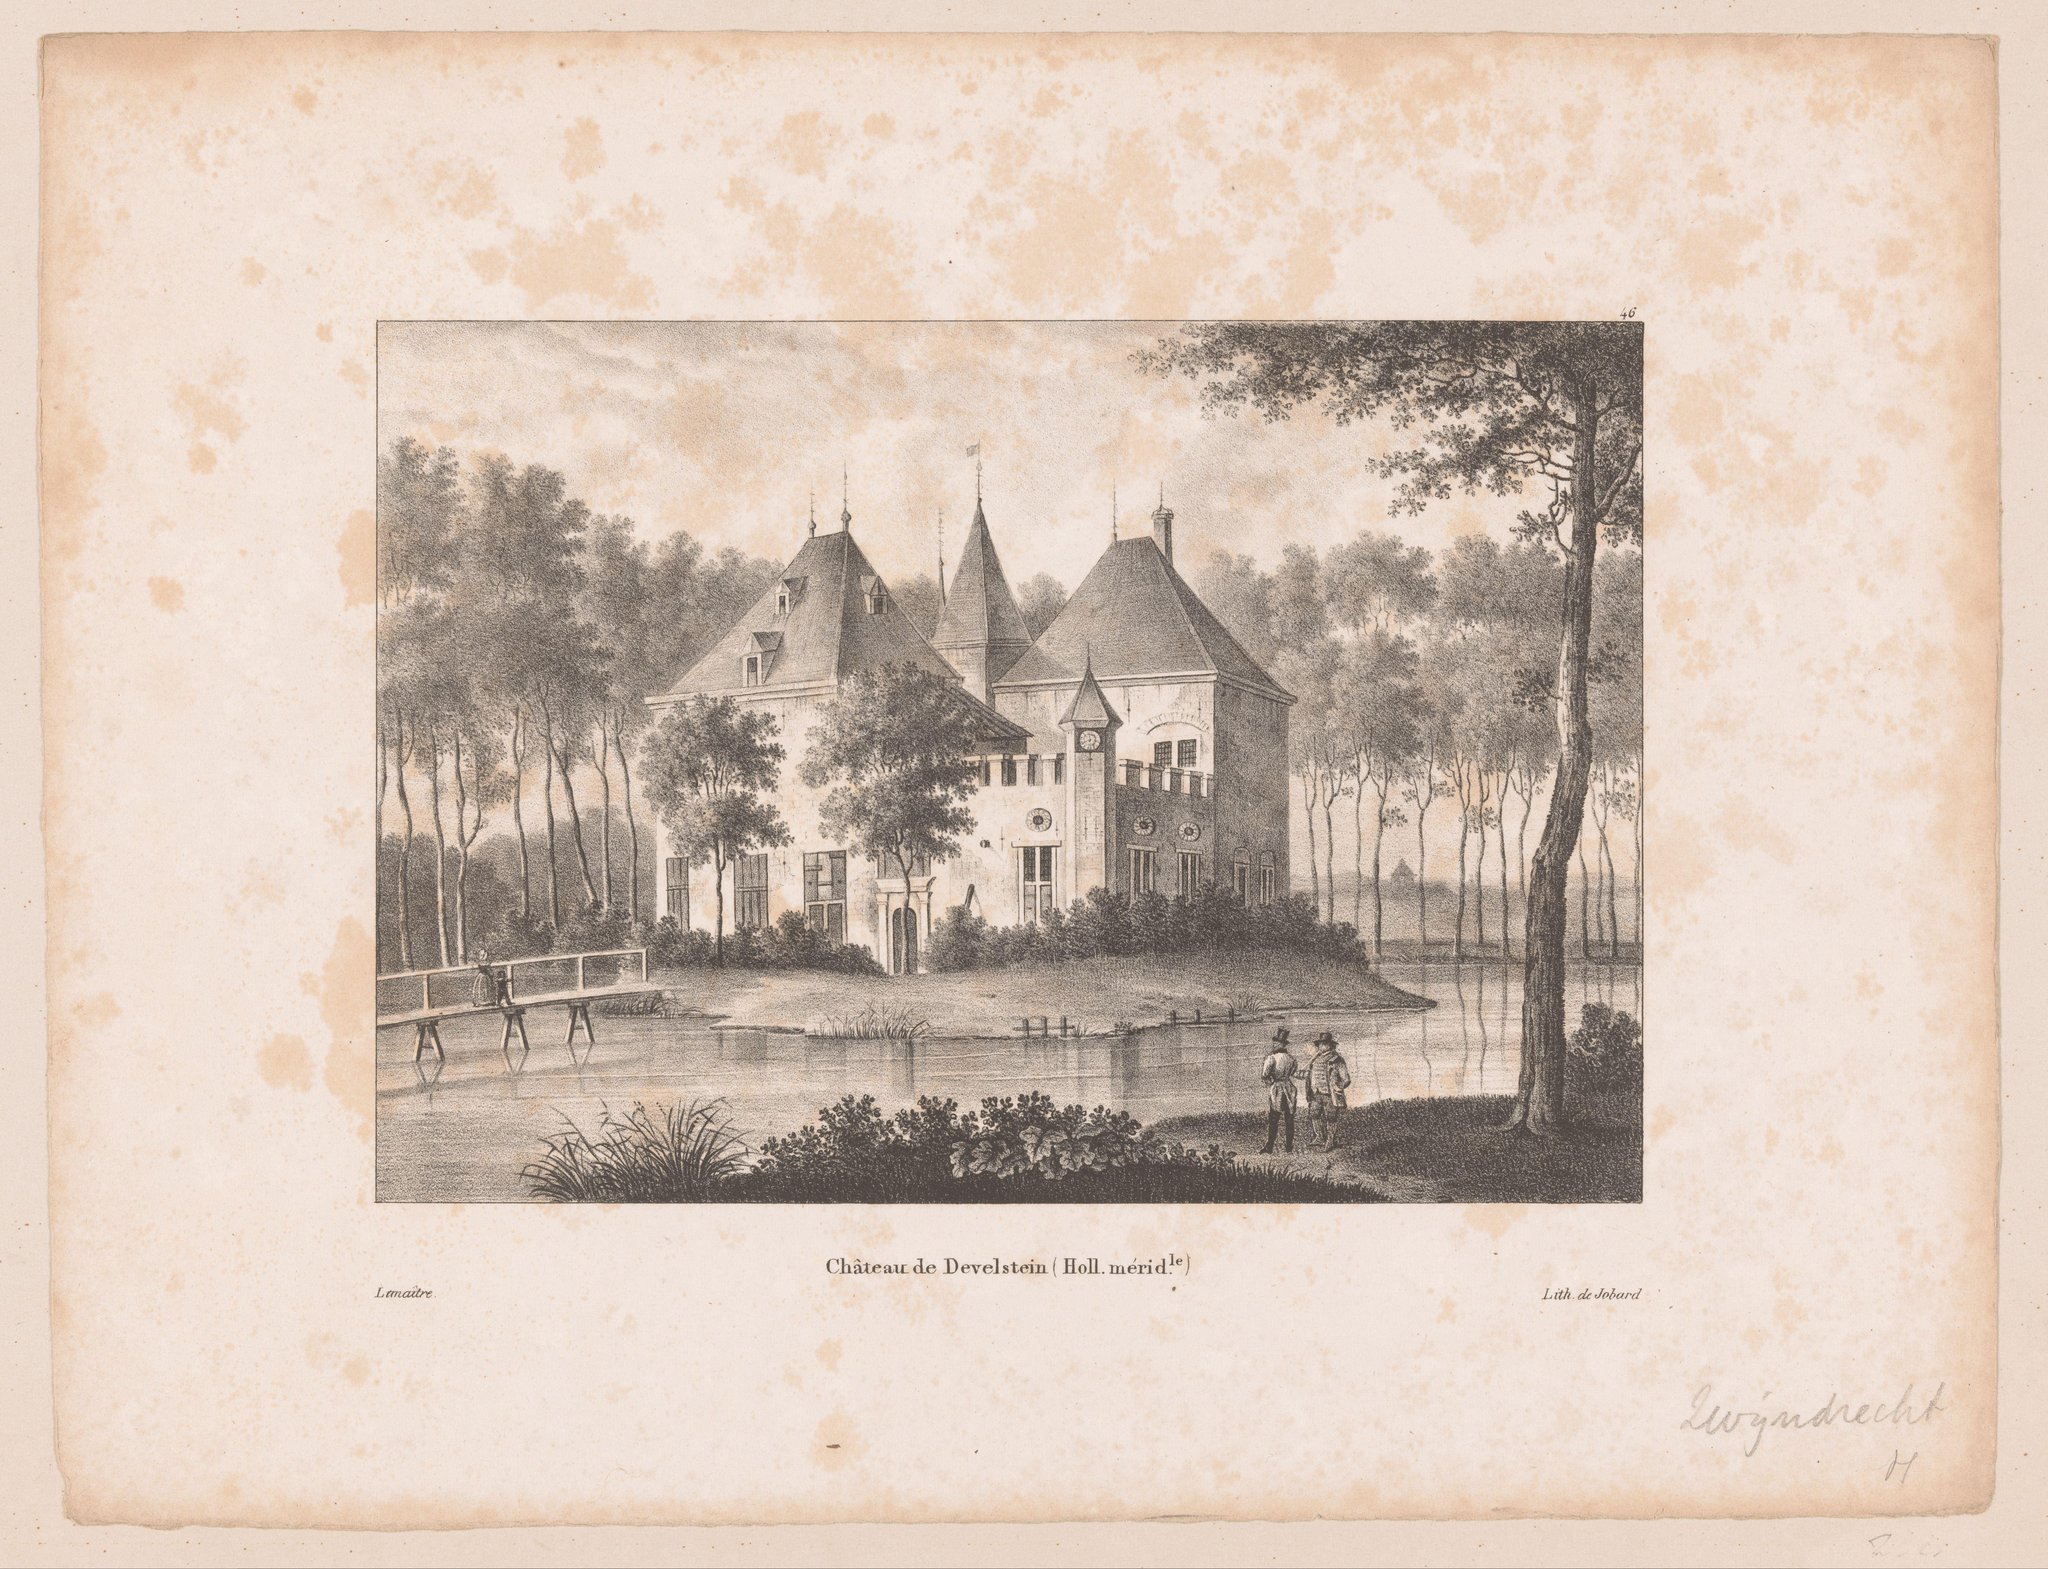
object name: print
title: Château de Develstein (Holl. mérid.1e)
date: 1820-1830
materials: paper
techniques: lithograph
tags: castle